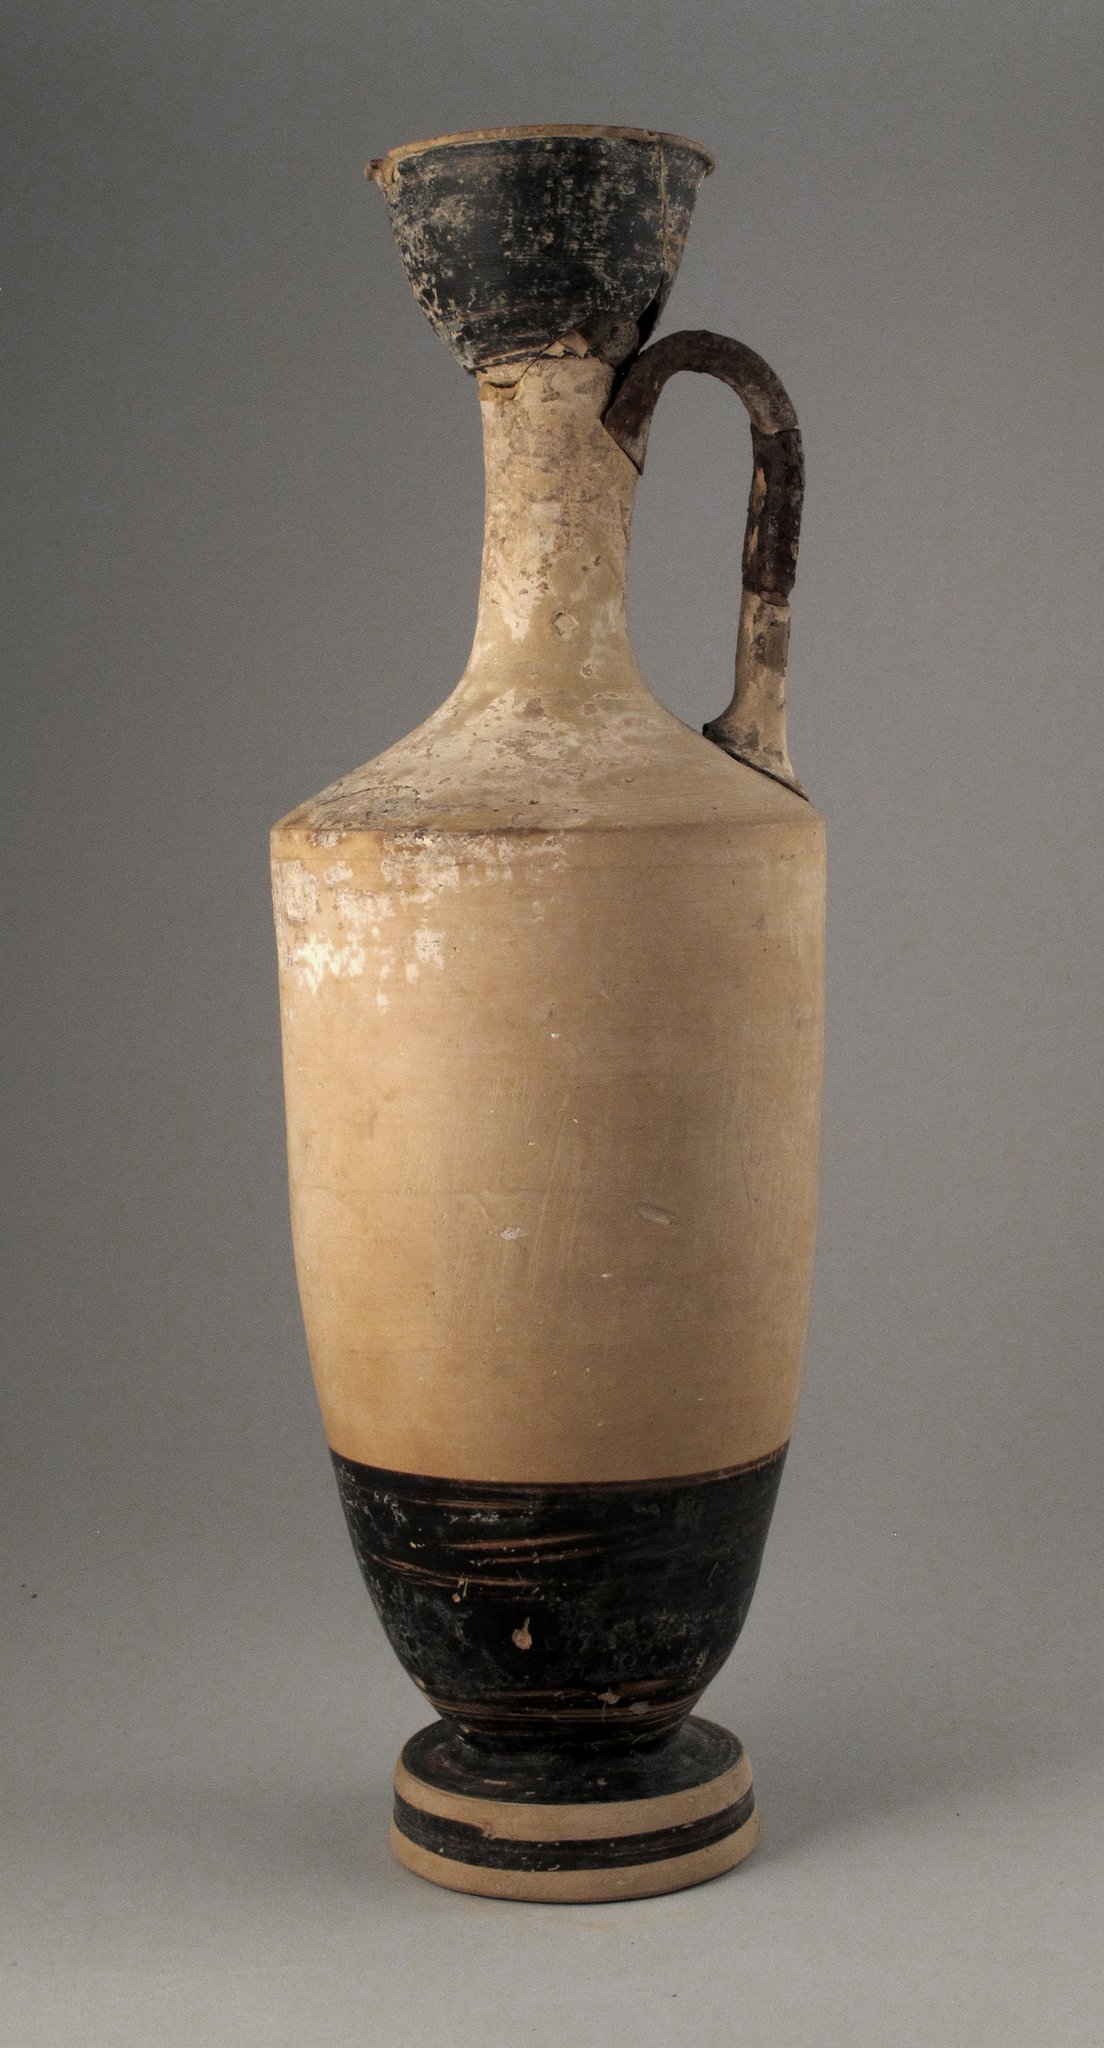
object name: lekythos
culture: greek, corinthian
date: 434-401 BCE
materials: terracotta